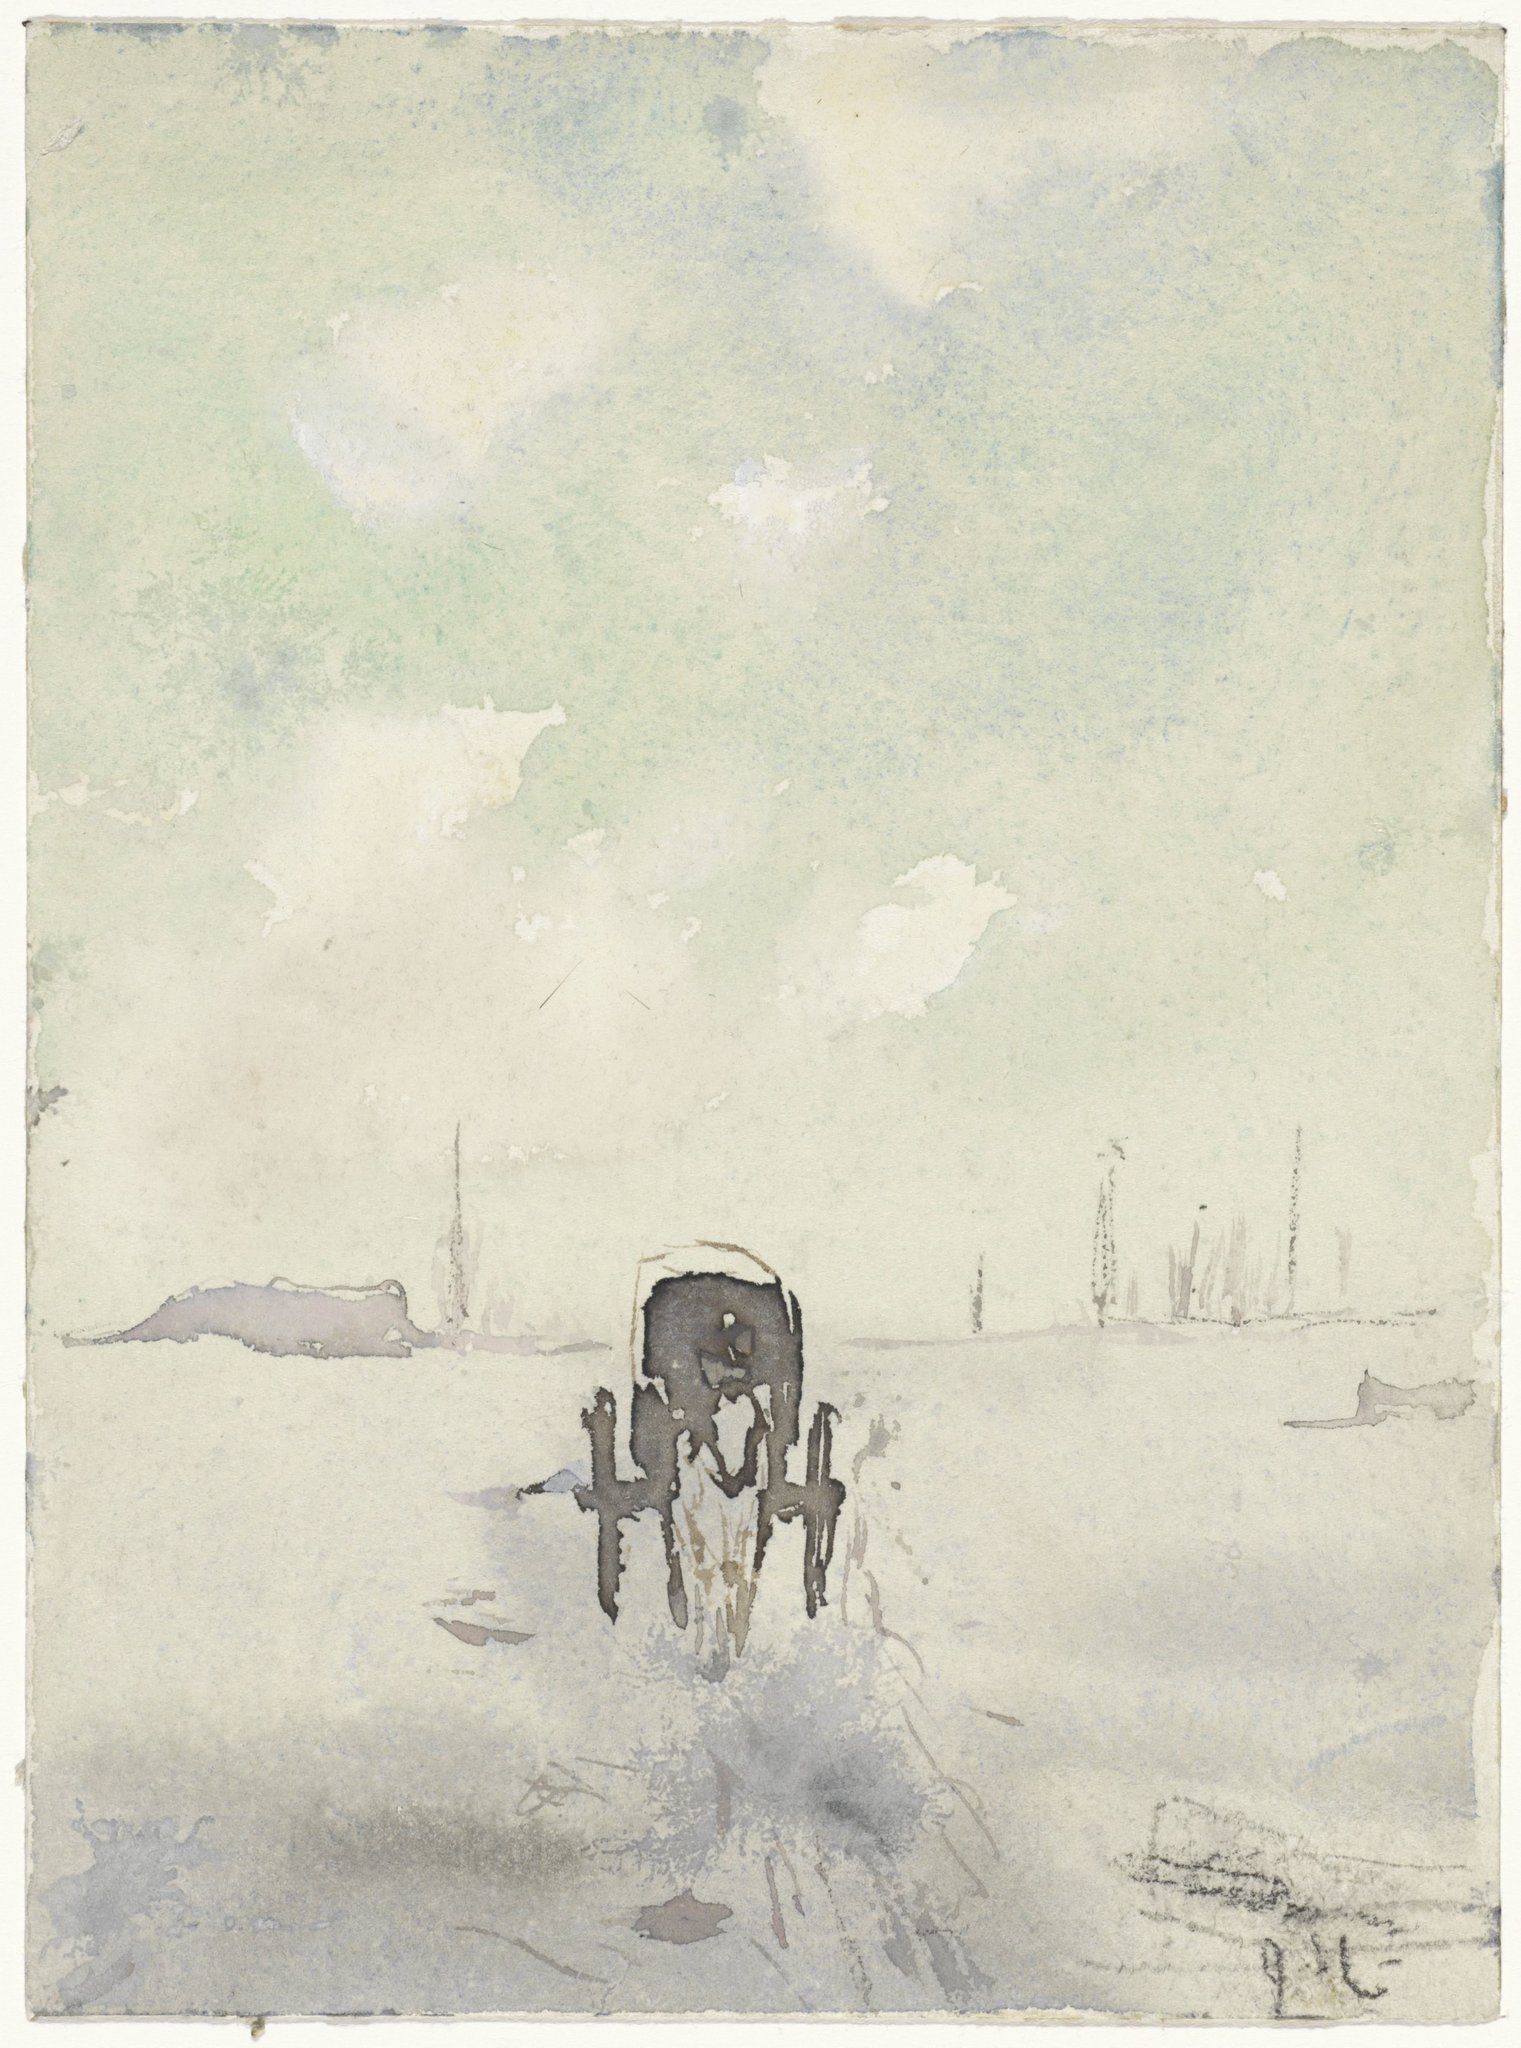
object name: drawing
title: Winterlandschap met paard en wagen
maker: adolf le comte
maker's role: draughtsman, painter, print maker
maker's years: 1850-1921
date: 1860-1921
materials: chalk, paper, watercolor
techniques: brush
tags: four-wheeled, animal-drawn vehicle, e.g.: cab, carriage, coach, snow